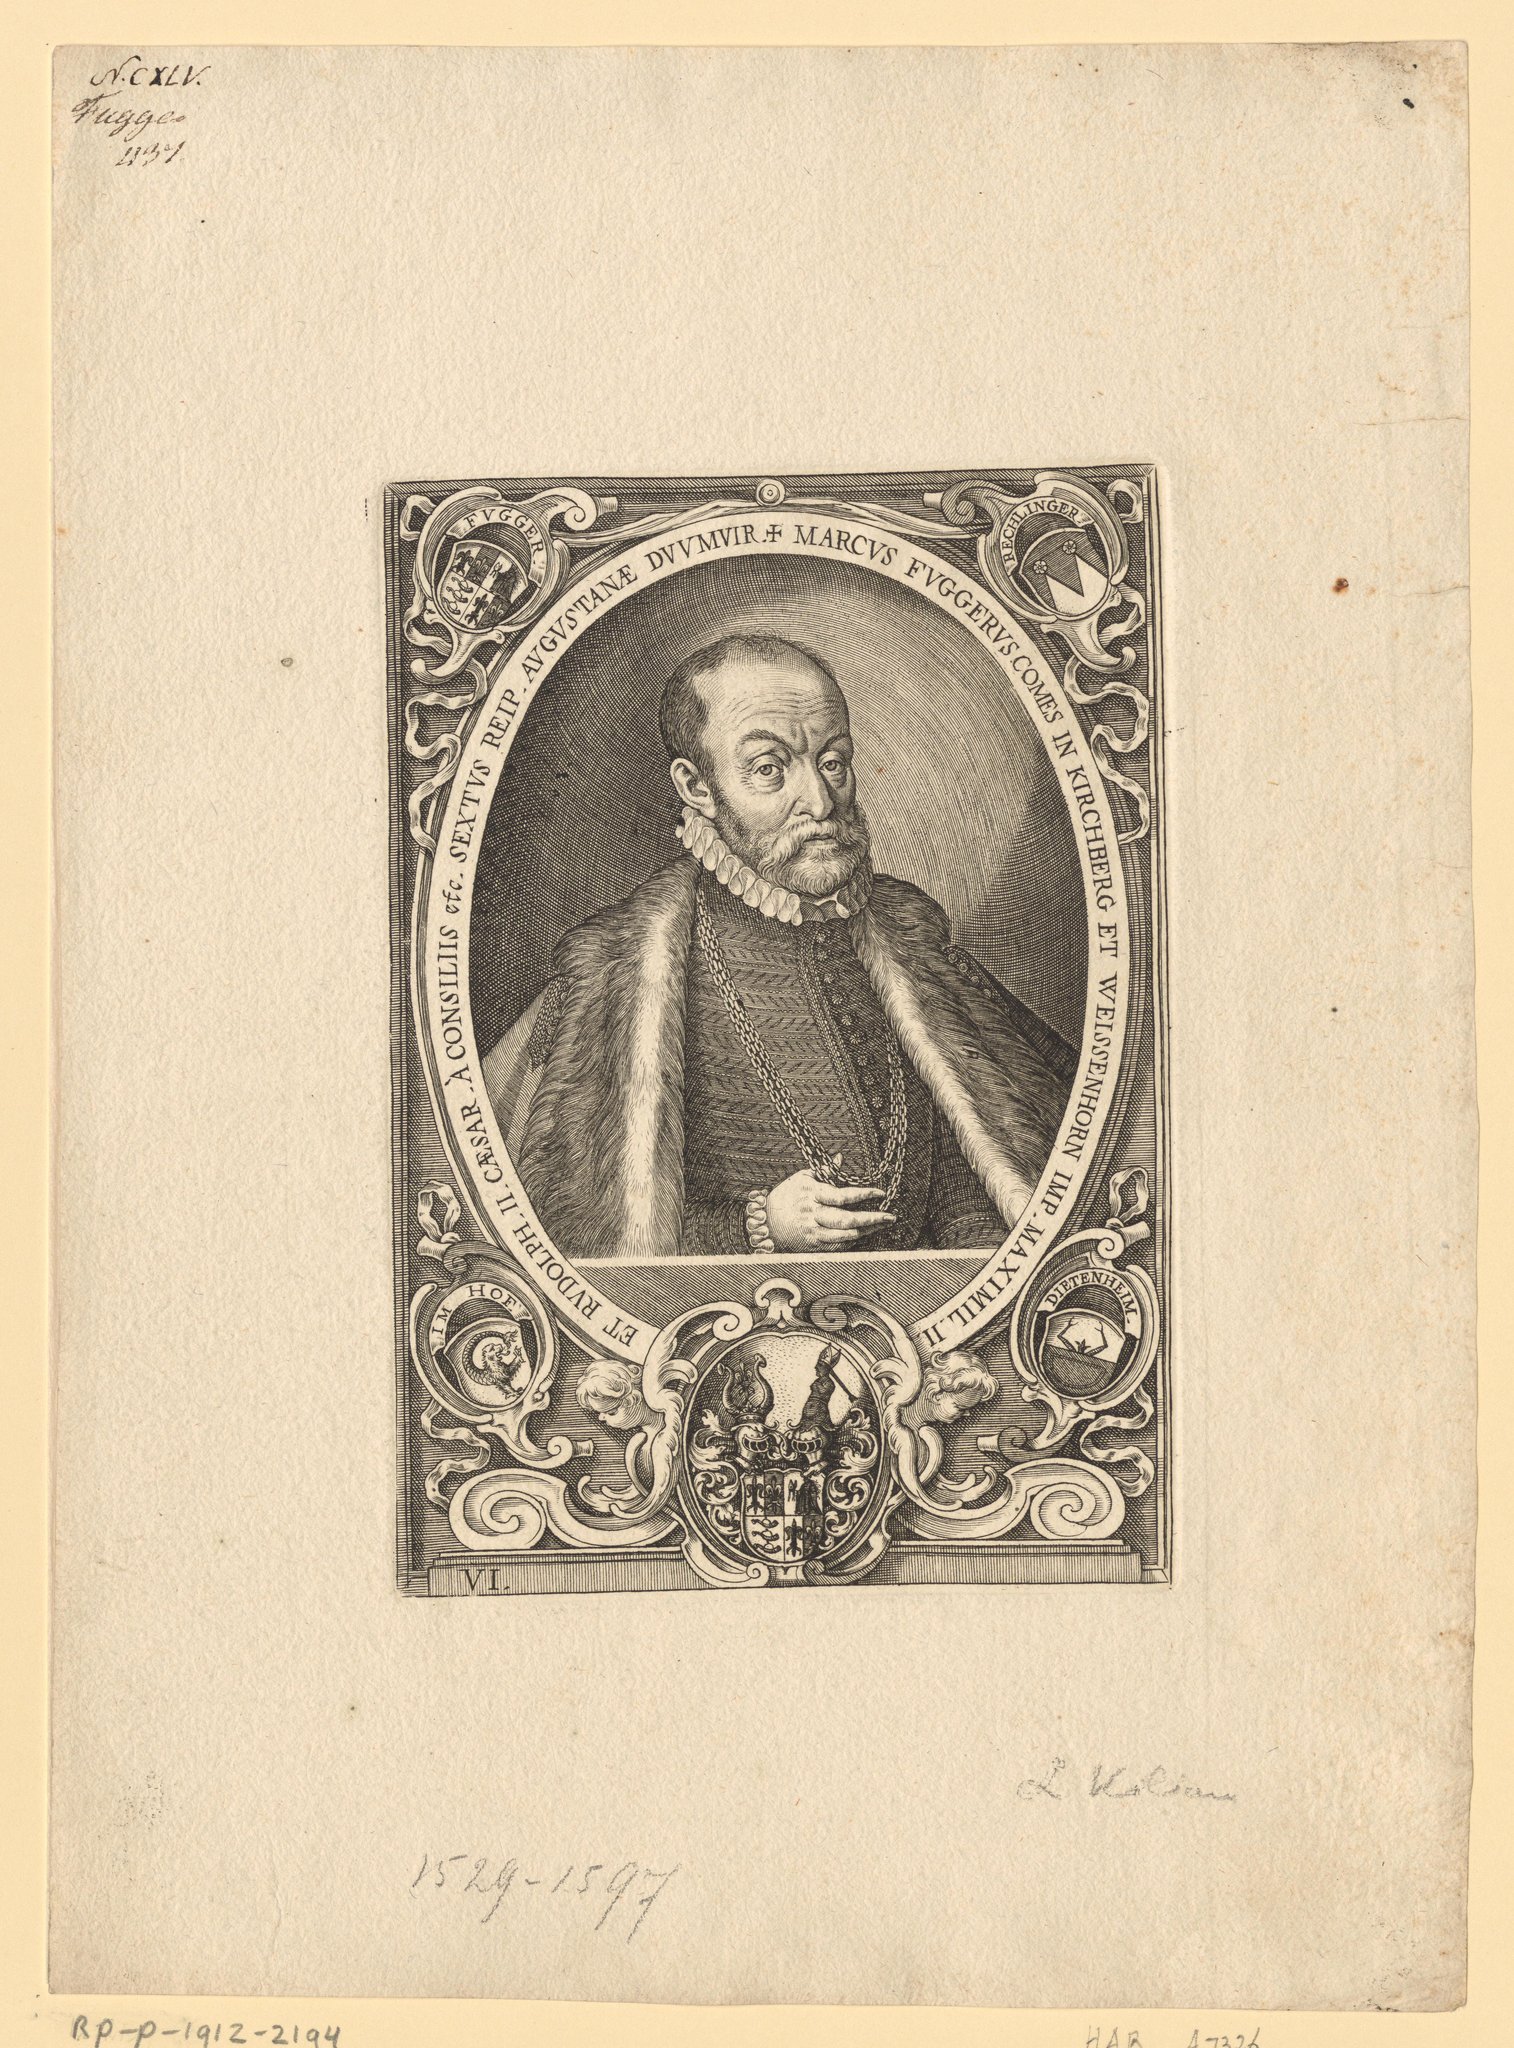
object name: print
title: Portret van Marcus Fugger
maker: lucas kilian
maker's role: draughtsman, print maker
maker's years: 1579-1637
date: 1615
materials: paper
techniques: engraving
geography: augsburg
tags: marcus fugger (baron van kirchberg en weissenhorn), historical persons, armorial bearing, heraldry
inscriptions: collector's mark: Lugt 2228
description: Prent is eerst gebruikt voor de serie door Lucas Kilian: Icones Omnium (...) Duumvirum, quotquot a prima Cardina Institutione usque ad praesentia Tempore Aerae Christ.M.DXCV. vixere. Hierin waren de titelpagina en de eerste veertien portretten door Lucas Kilian opgenomen. De prent is met tekst in boekdruk op verso gebruikt in: Kilian, Lucas. Imp. Caes. Caroli V.S.A. Decreto et auspiciis (...) formis expressi MDCXXIV. Augsburg: Lucas Kilian, 1624. De versie uit 1624 bevat ook portretten door Wolfgang Kilian.